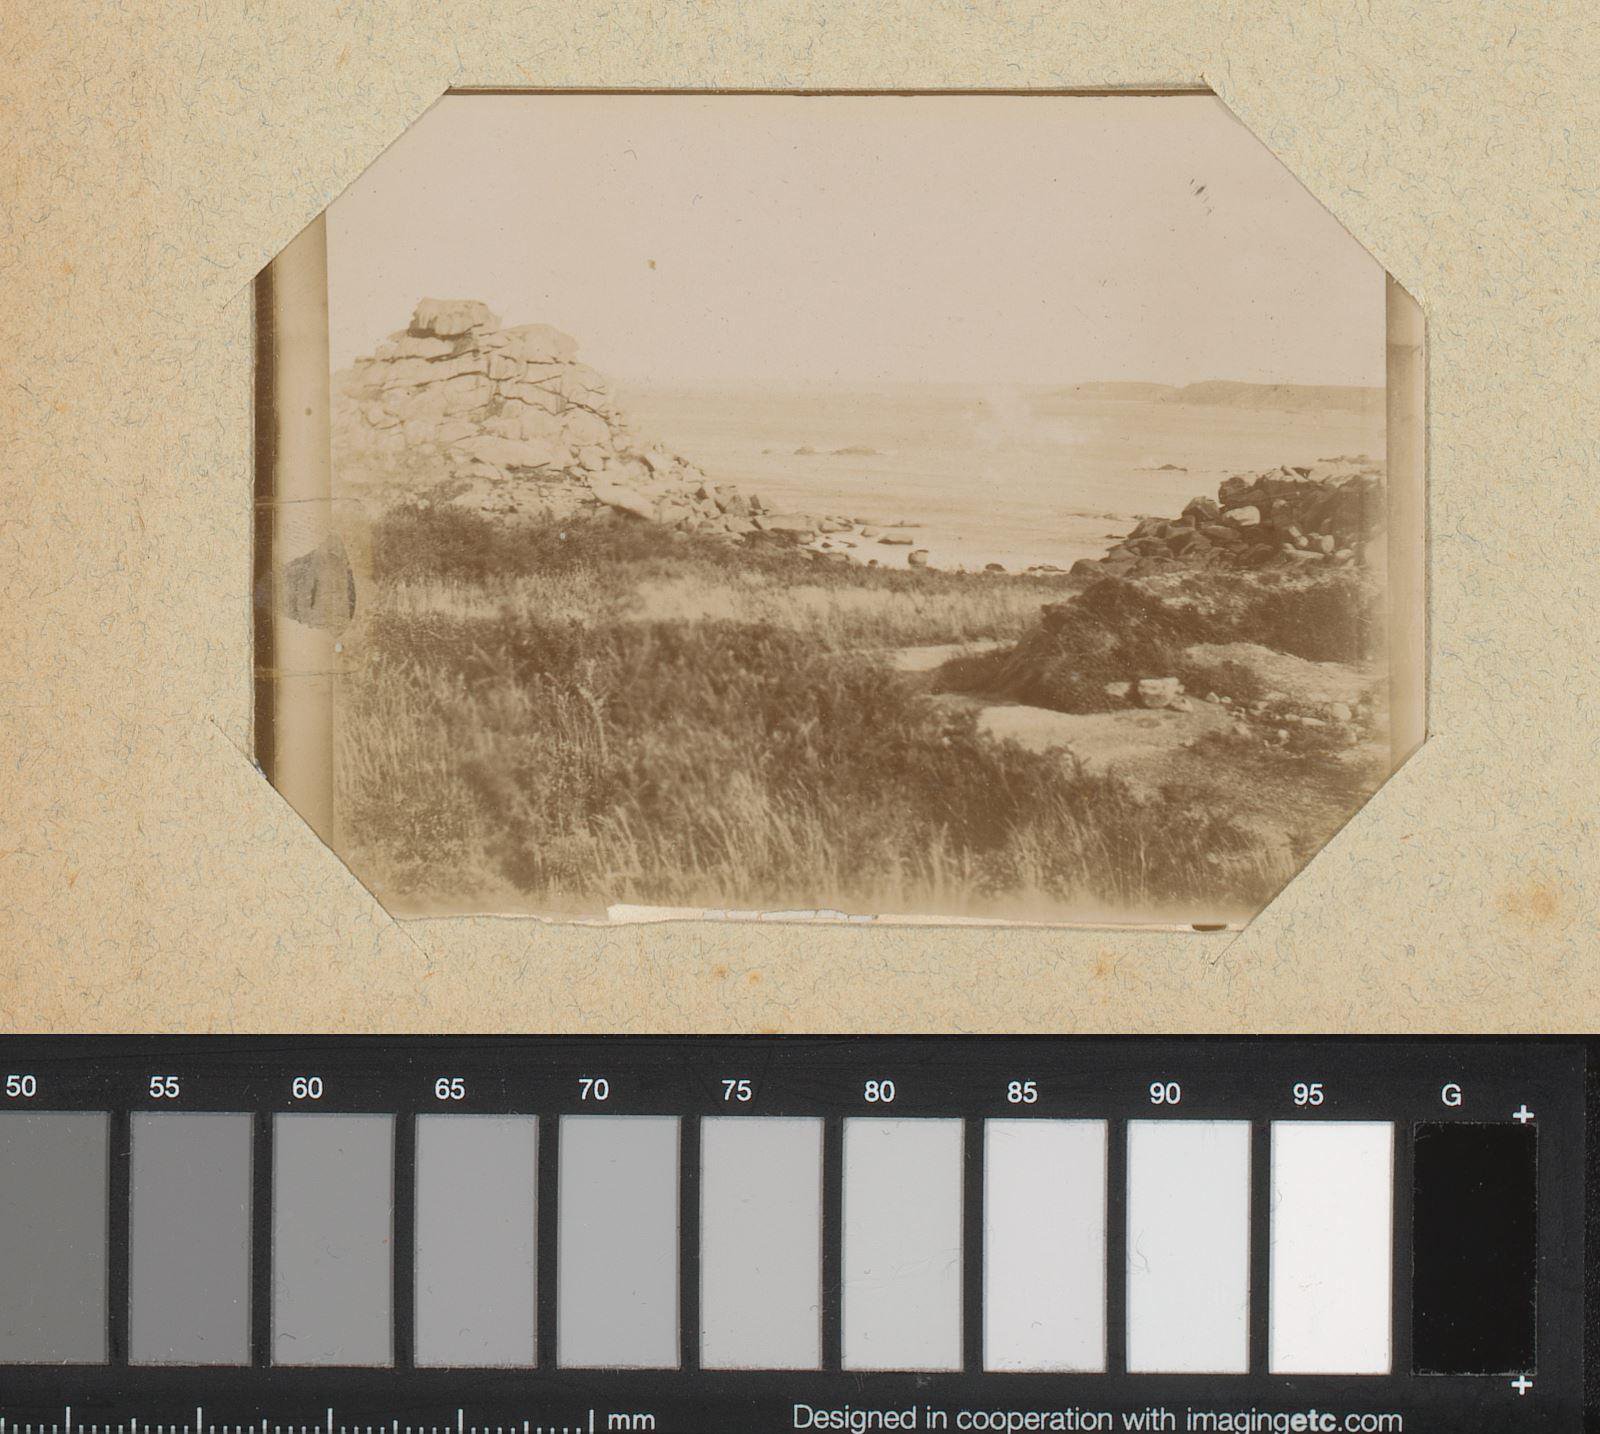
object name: photograph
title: Rotskust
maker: Anonymous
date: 1897-1900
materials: paper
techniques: gelatin silver print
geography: france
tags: rocky coast, france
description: Over de foto is een ander negatief afgedrukt van een voorstelling van bomen.